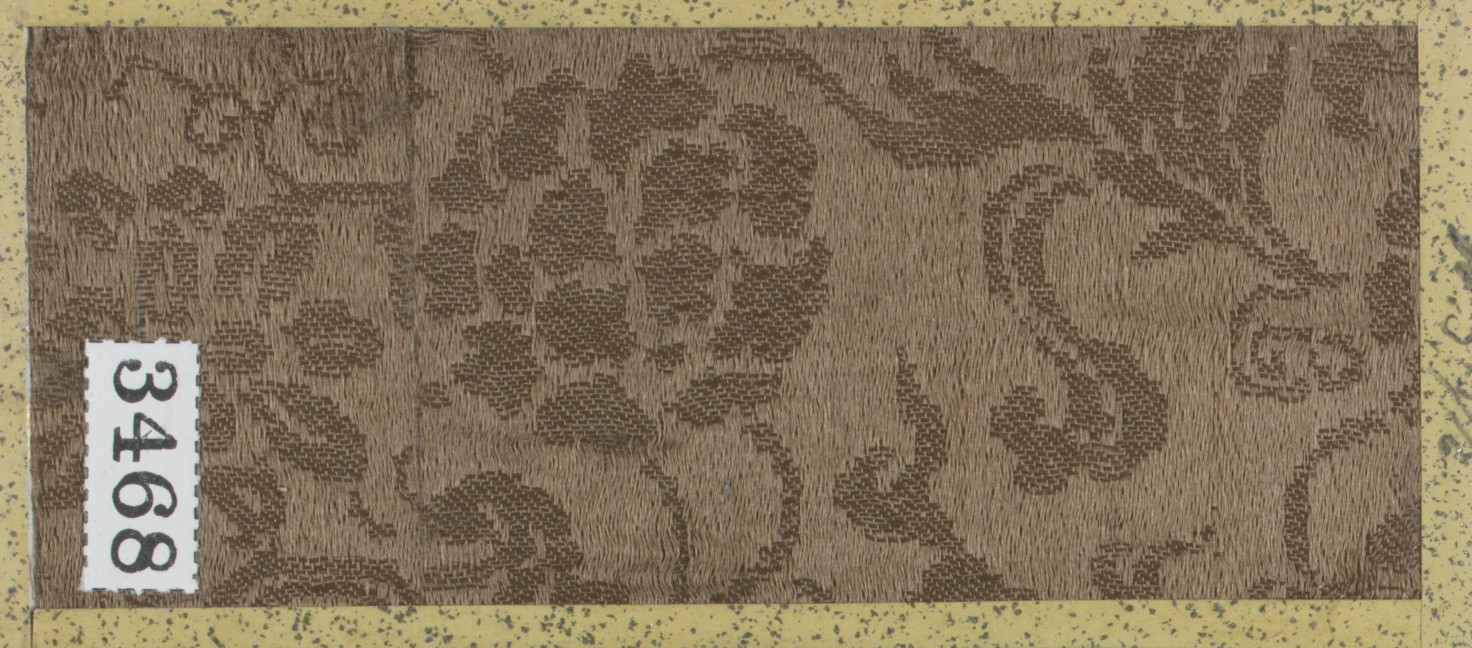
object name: sample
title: Textile Sample from Sample Book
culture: japanese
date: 1801-1900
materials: silk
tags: flowers